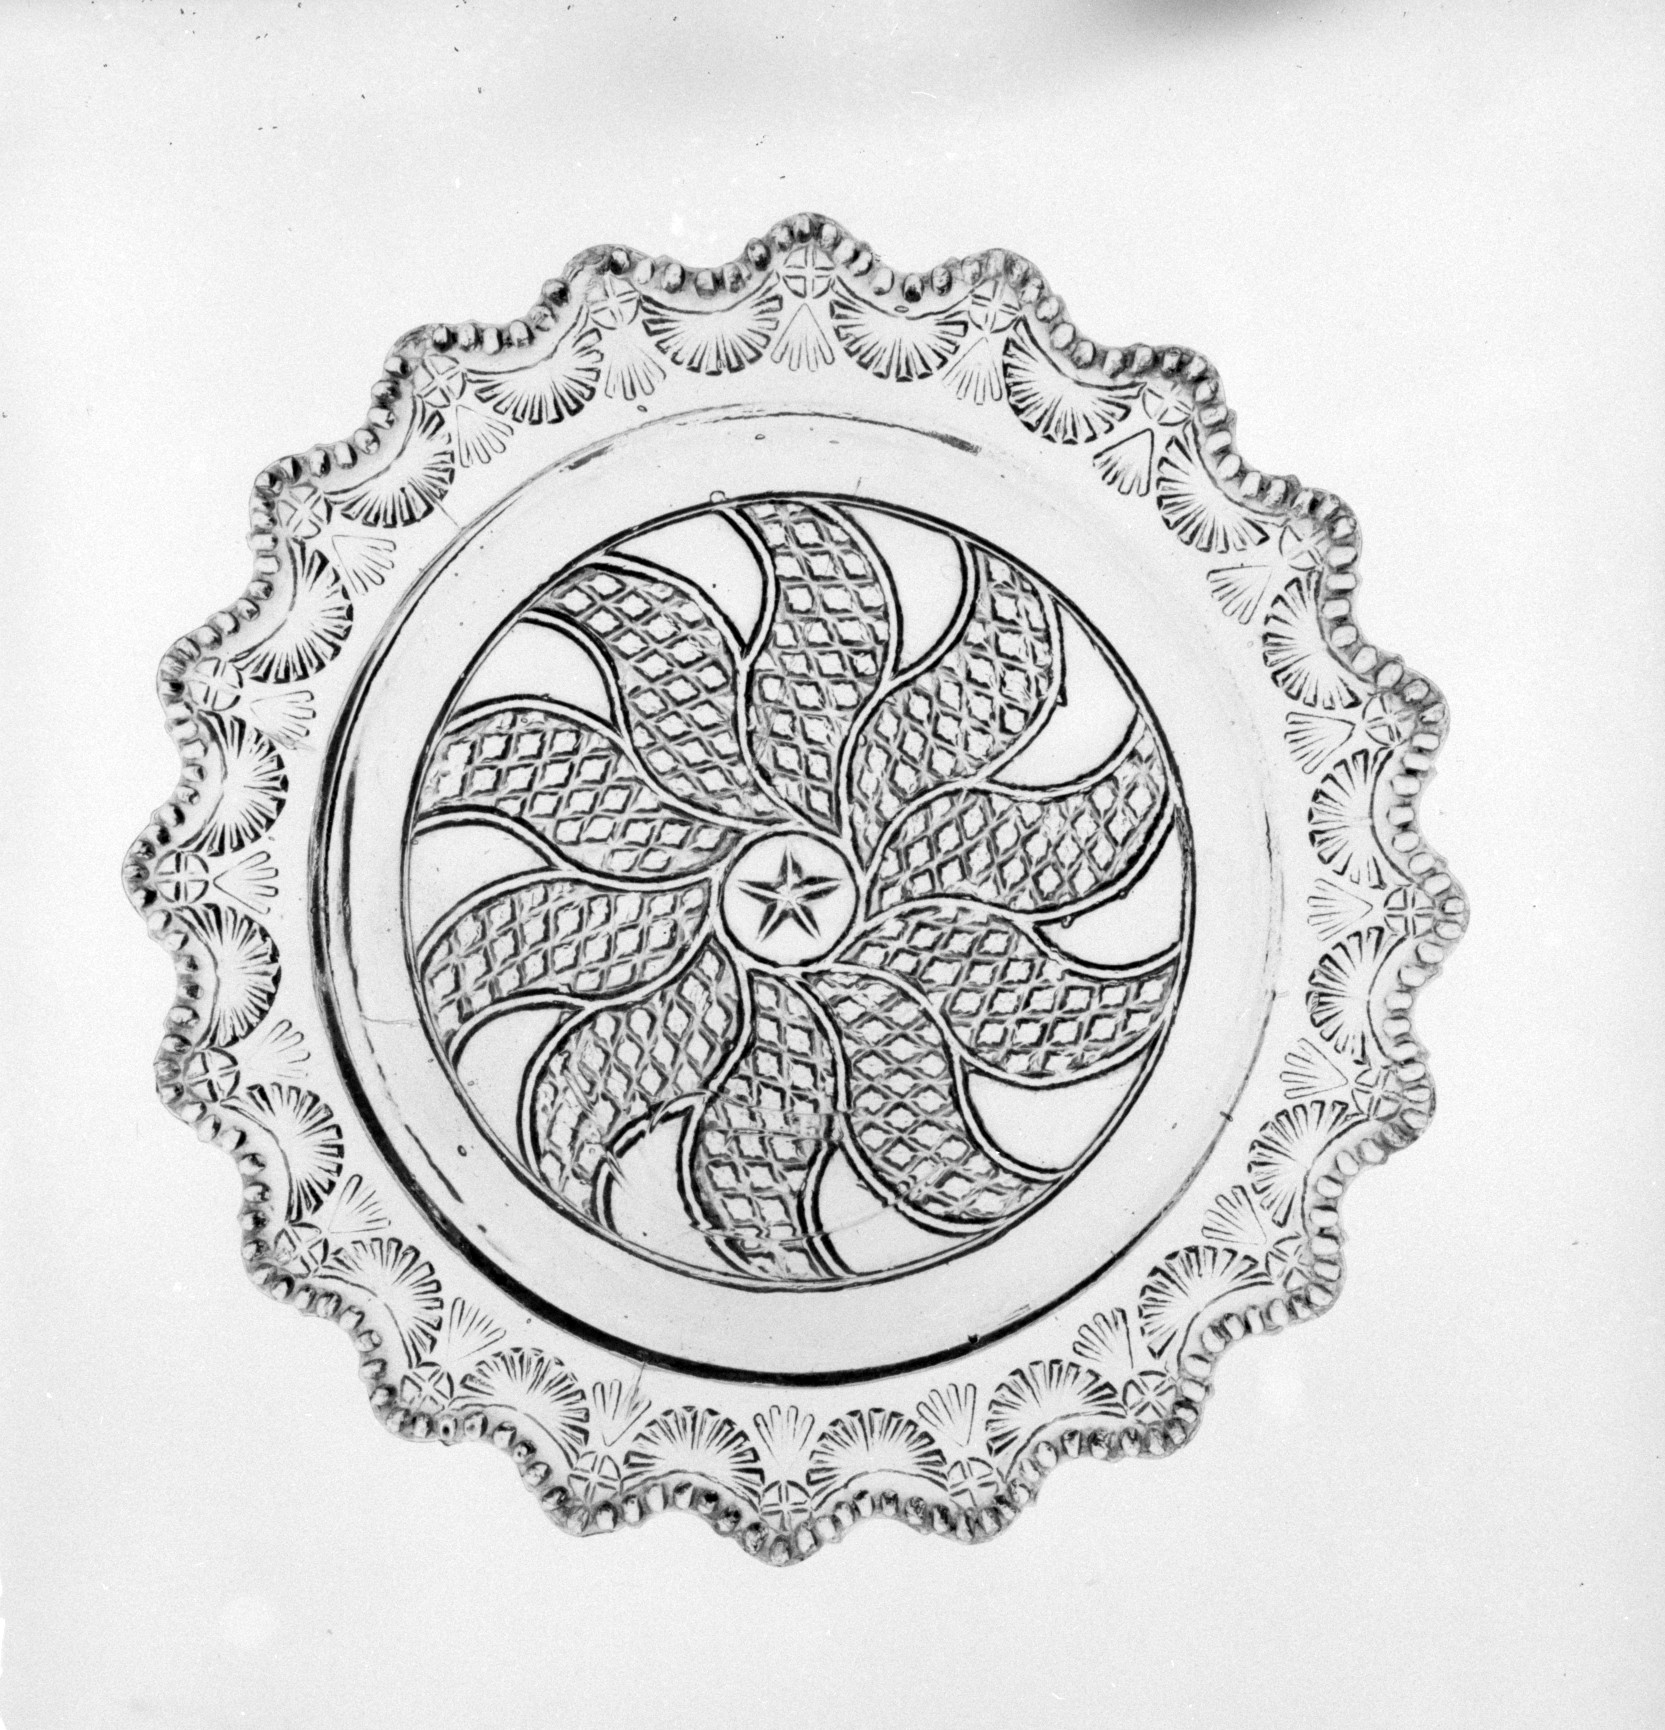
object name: dish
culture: american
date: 1830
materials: glass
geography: united states